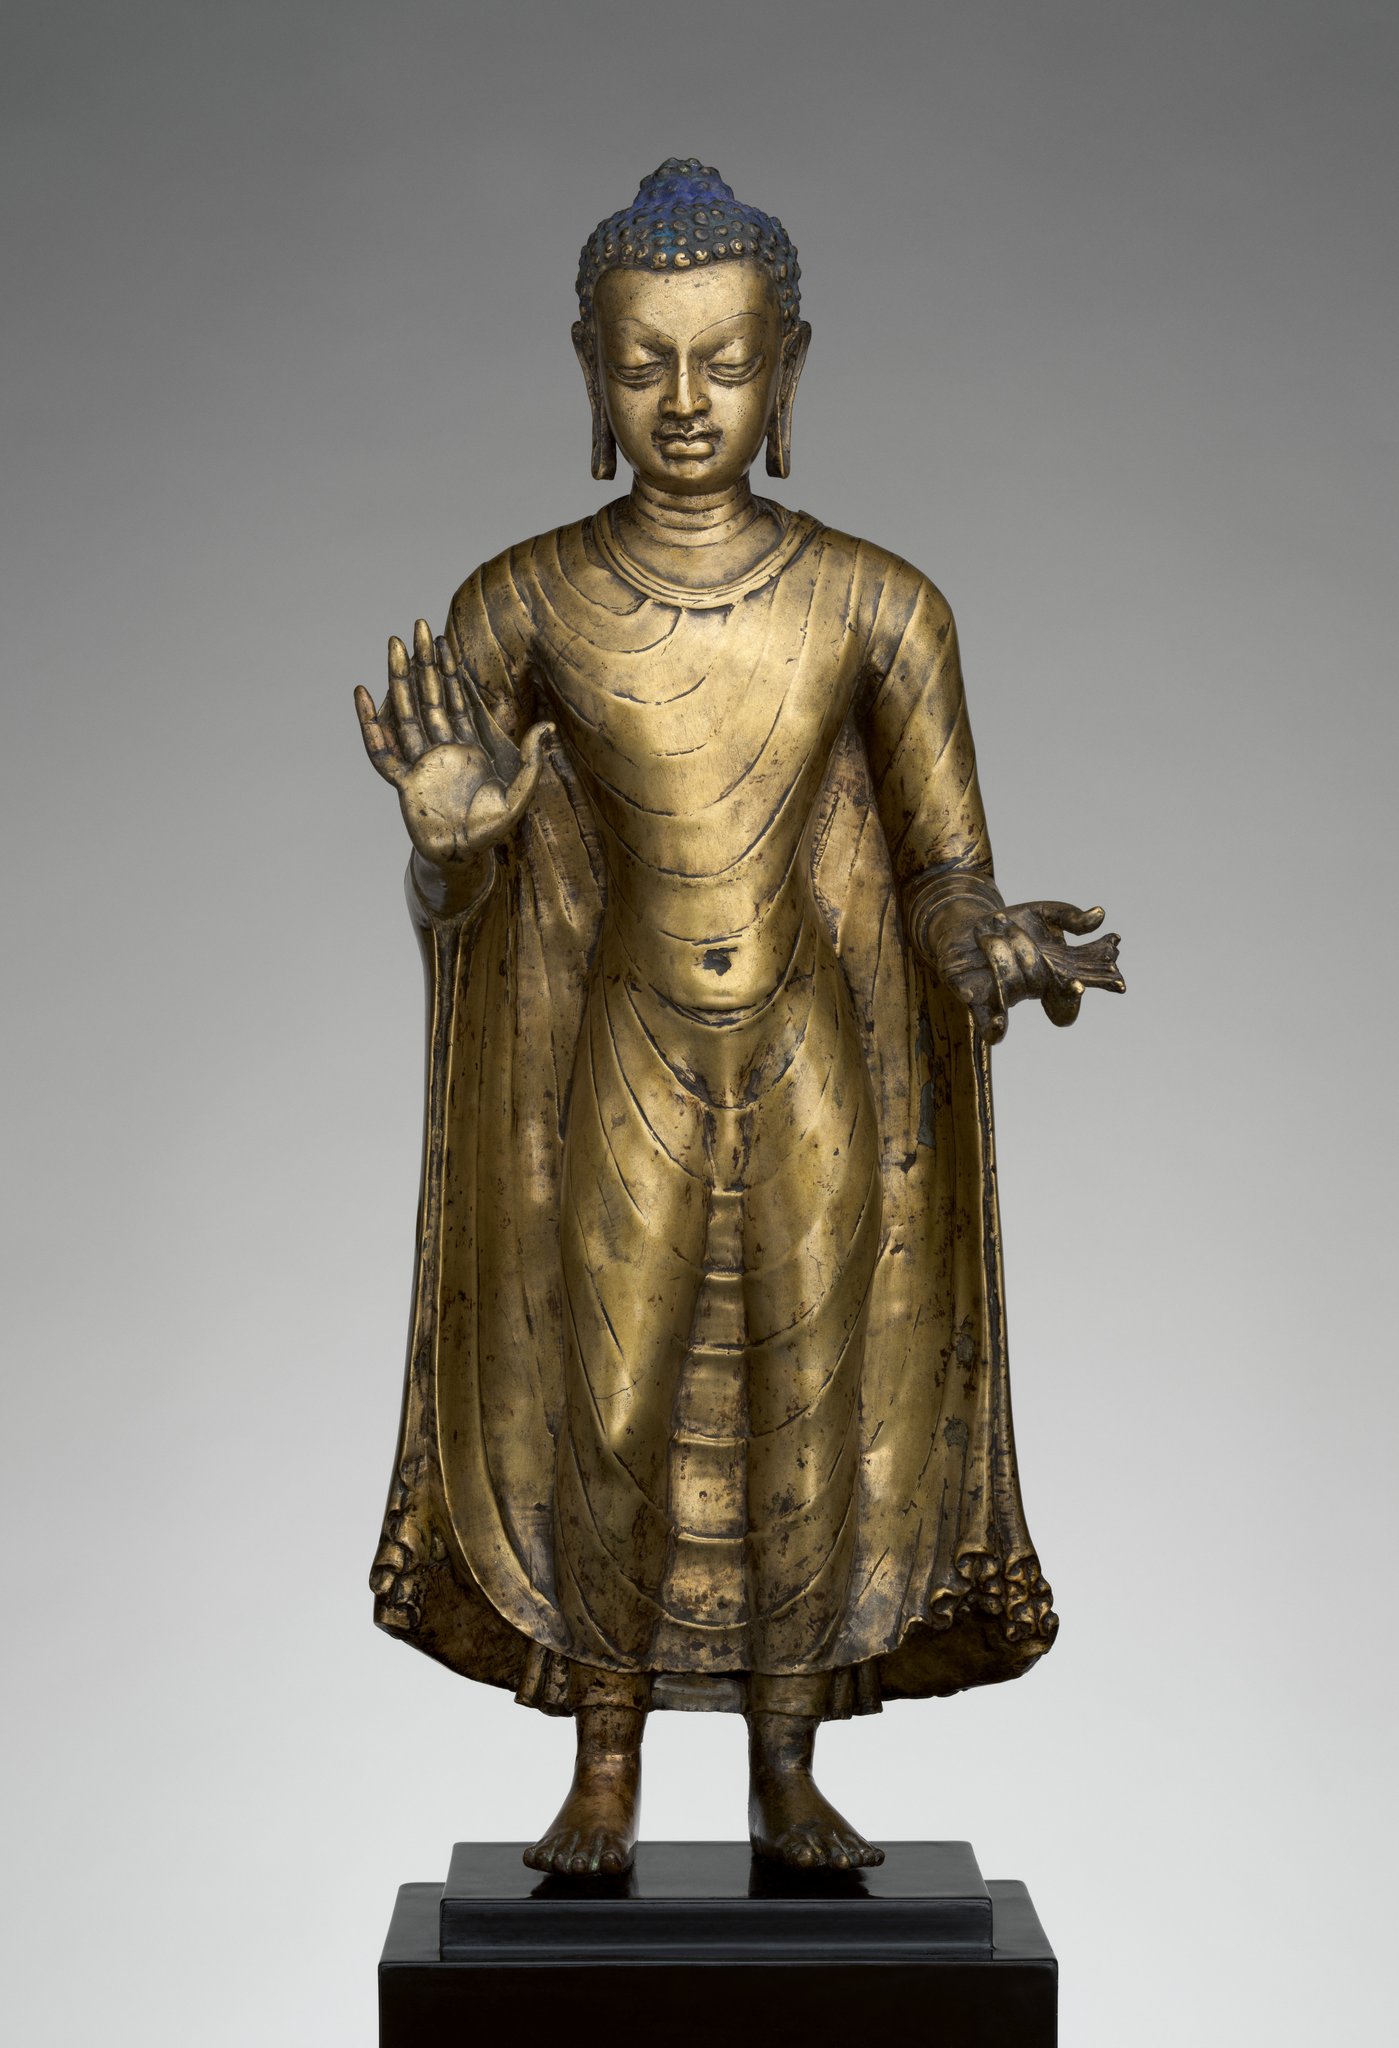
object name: figure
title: Buddha Offering Protection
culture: indian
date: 567-633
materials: copper alloy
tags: post-gupta,buddhism,buddha